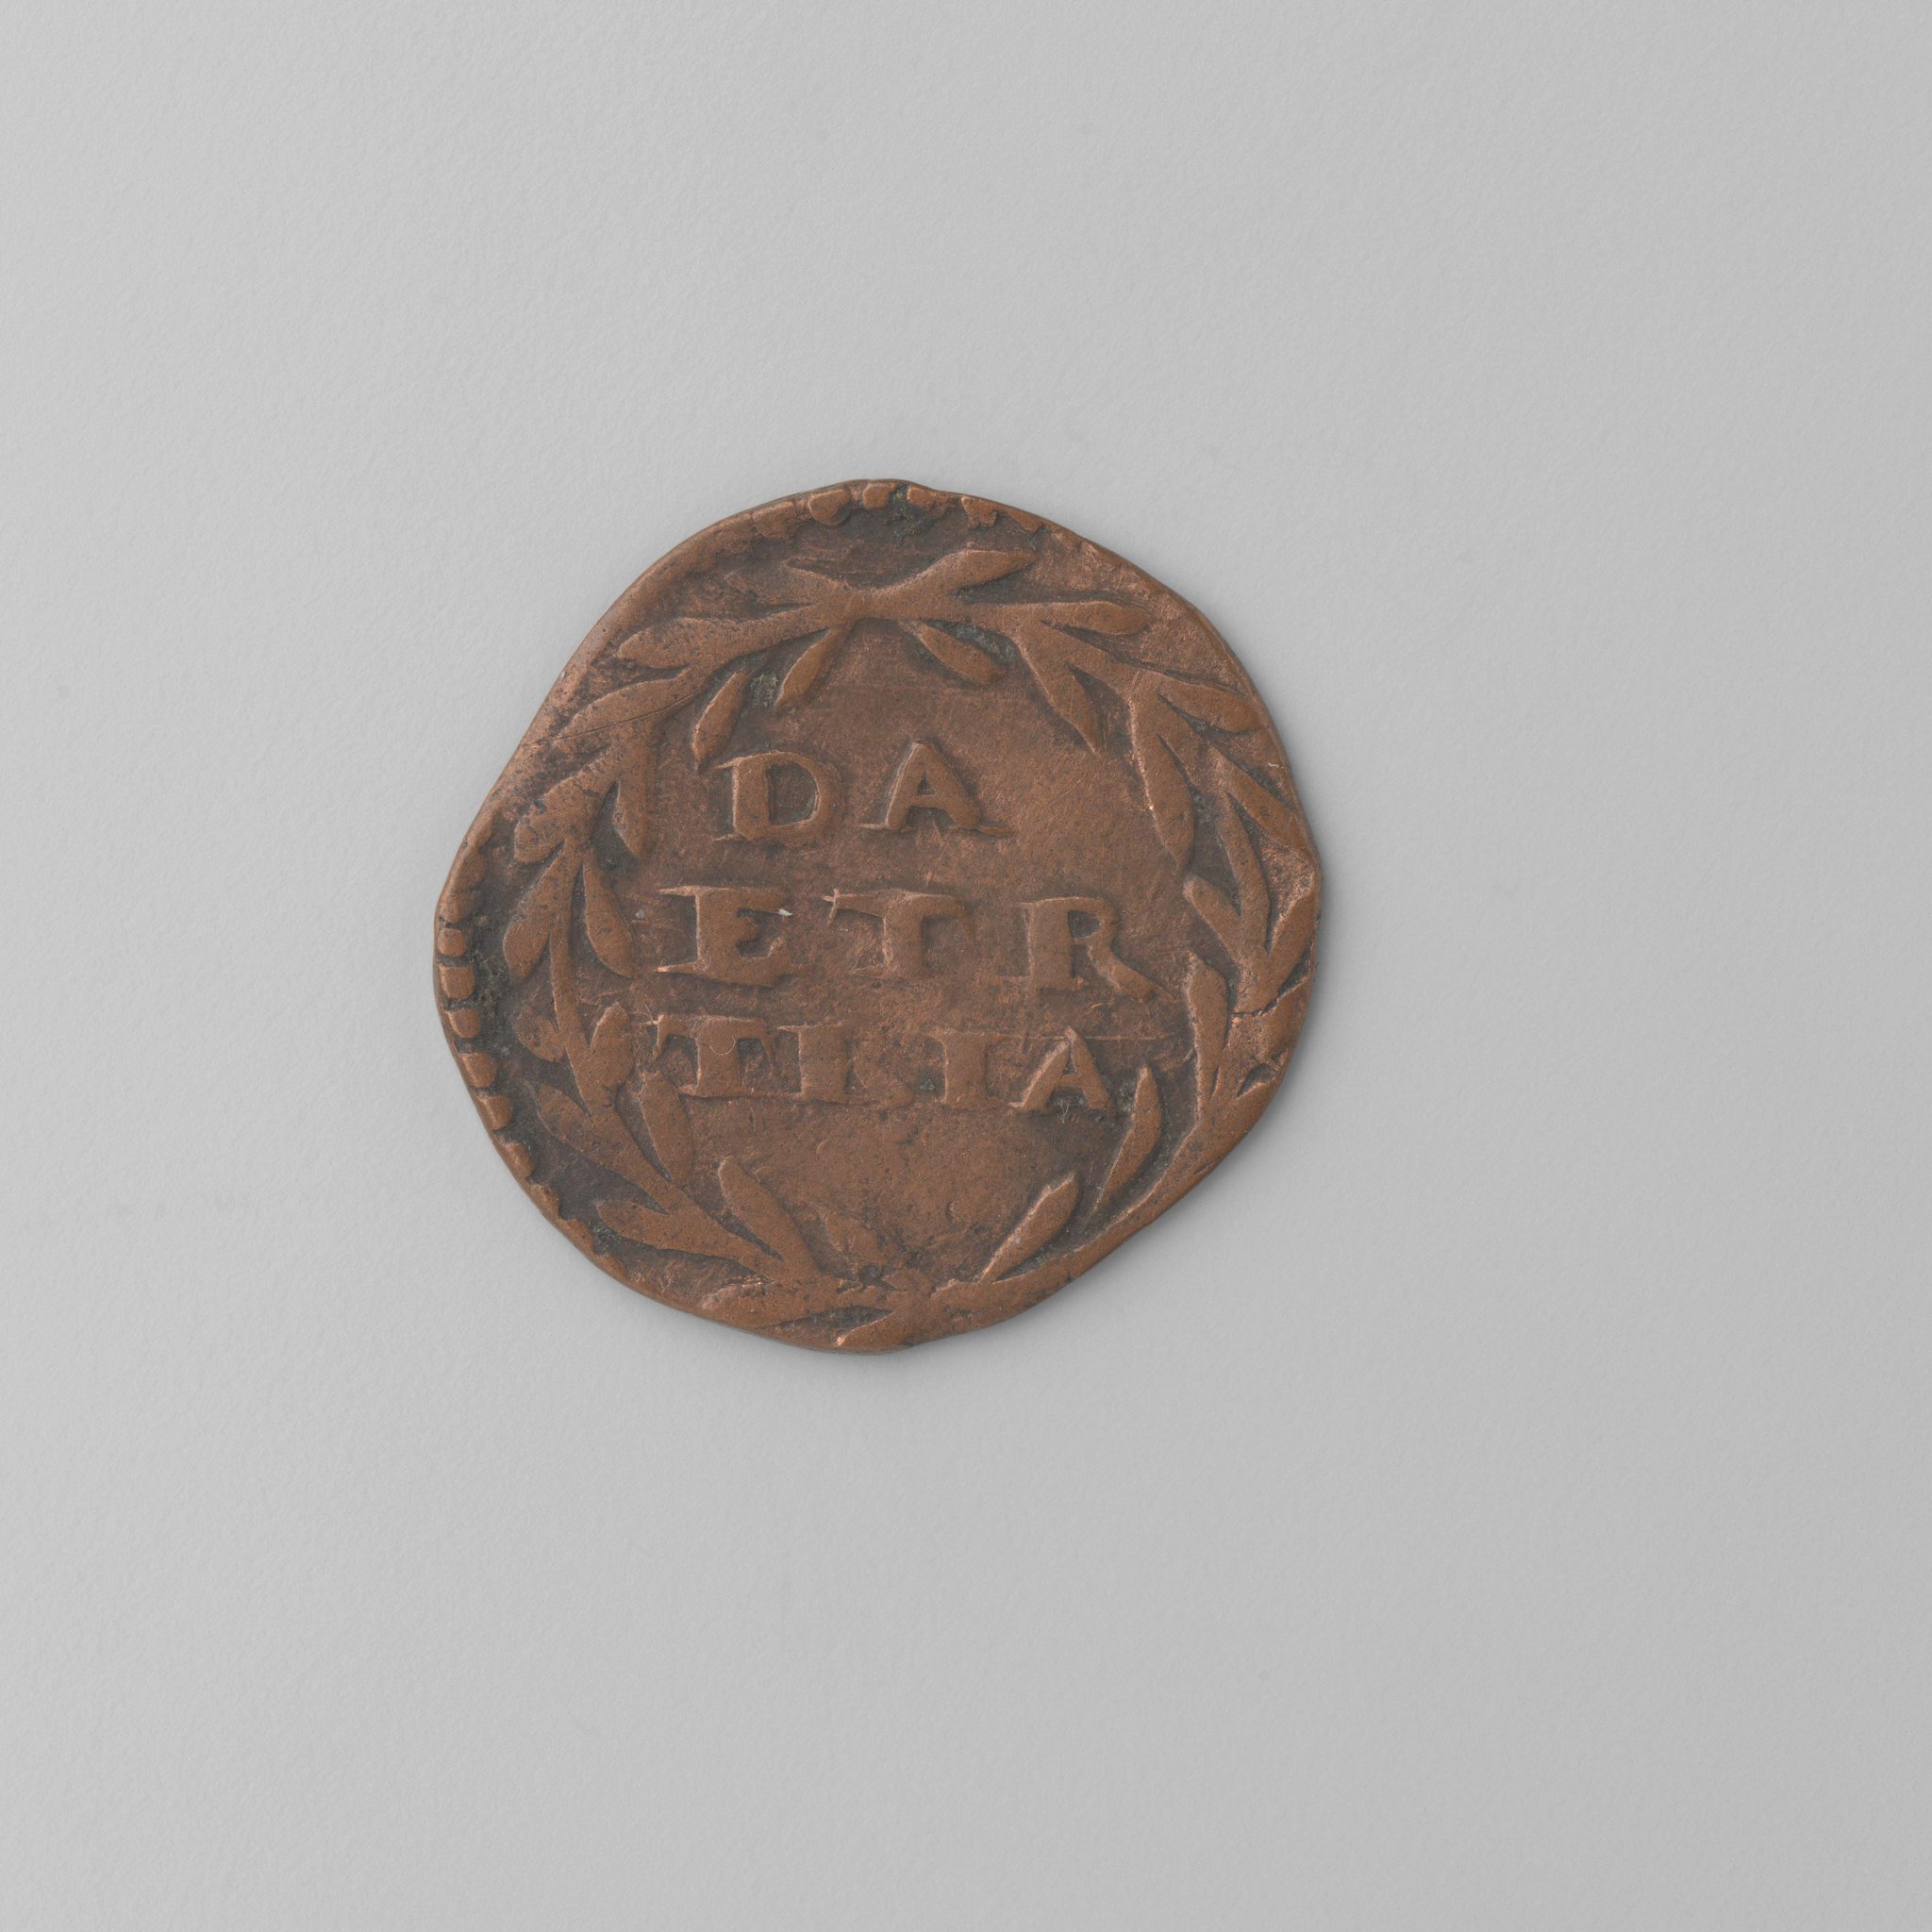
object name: coin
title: Reckheimse duit van Ferdinand van Aspremont-Lynden (1636-1665)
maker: heer van reckheim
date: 1636-1665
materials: copper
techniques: striking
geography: rekem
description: Koperen munt. Voorzijde: versierd gekroond wapenschild van Deventer. Keerzijde: binnen een krans drie-regelig opschrift.